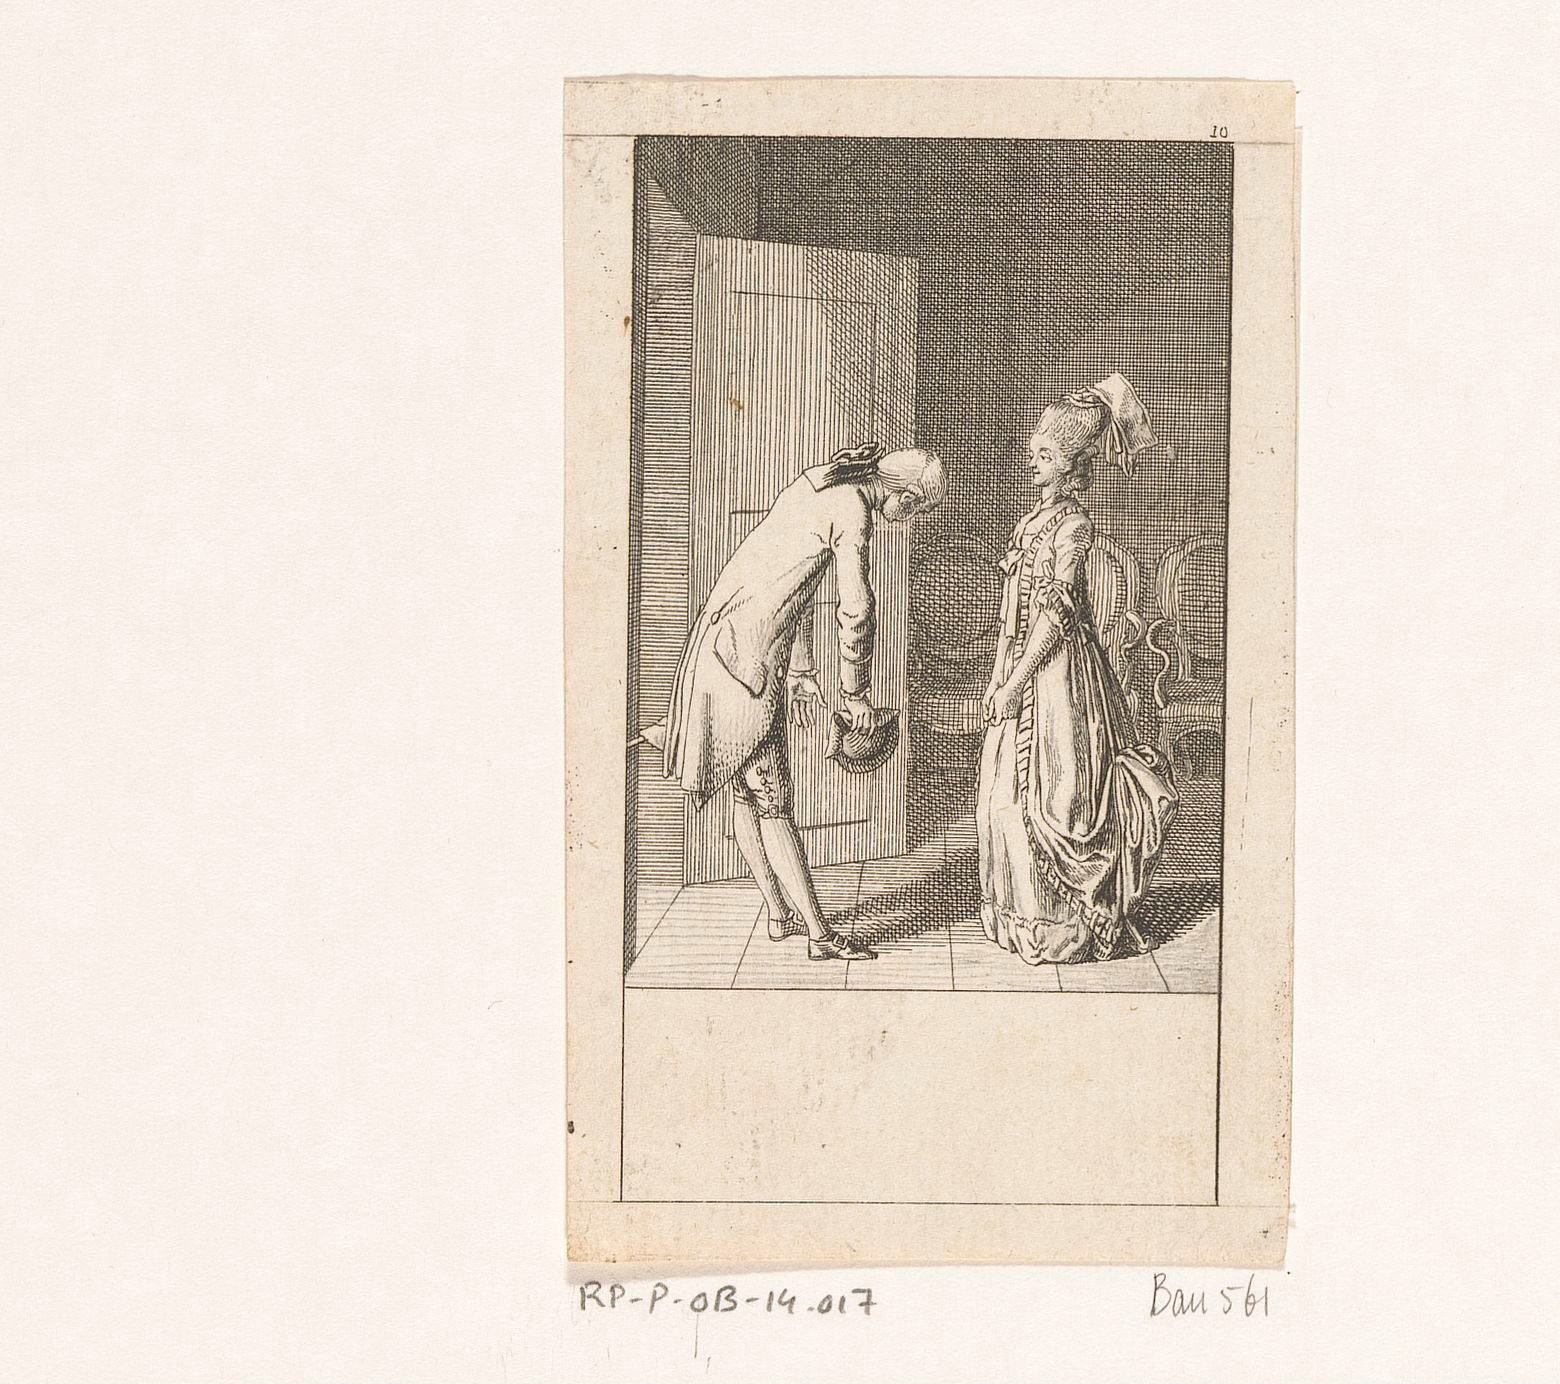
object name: print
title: Begroeting bij binnenkomst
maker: daniel nikolaus chodowiecki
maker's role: draughtsman, print maker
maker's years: 1726-1801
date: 1778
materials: paper, pencil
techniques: etching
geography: berlin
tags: physicist, head bent forward; bowing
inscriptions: collector's mark: Lugt 2228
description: Tiende prent uit een serie van twaalf taferelen die 'Natürliche und affectirte Handlungen des Lebens' (eerste serie) illustreren waarin 'natuurlijk' en 'geaffecteerd' gedrag op karikaturale wijze tegenover elkaar worden gezet. Deze taferelen zijn op een plaat geëtst. Een latere staat van deze serie, voorzien van toelichtingen door Georg Christoph Lichtenberg, is ook gebruikt in: Goettinger Taschen Calender vom Jahre 1779. Göttingen: Johann Christian Dieterich.